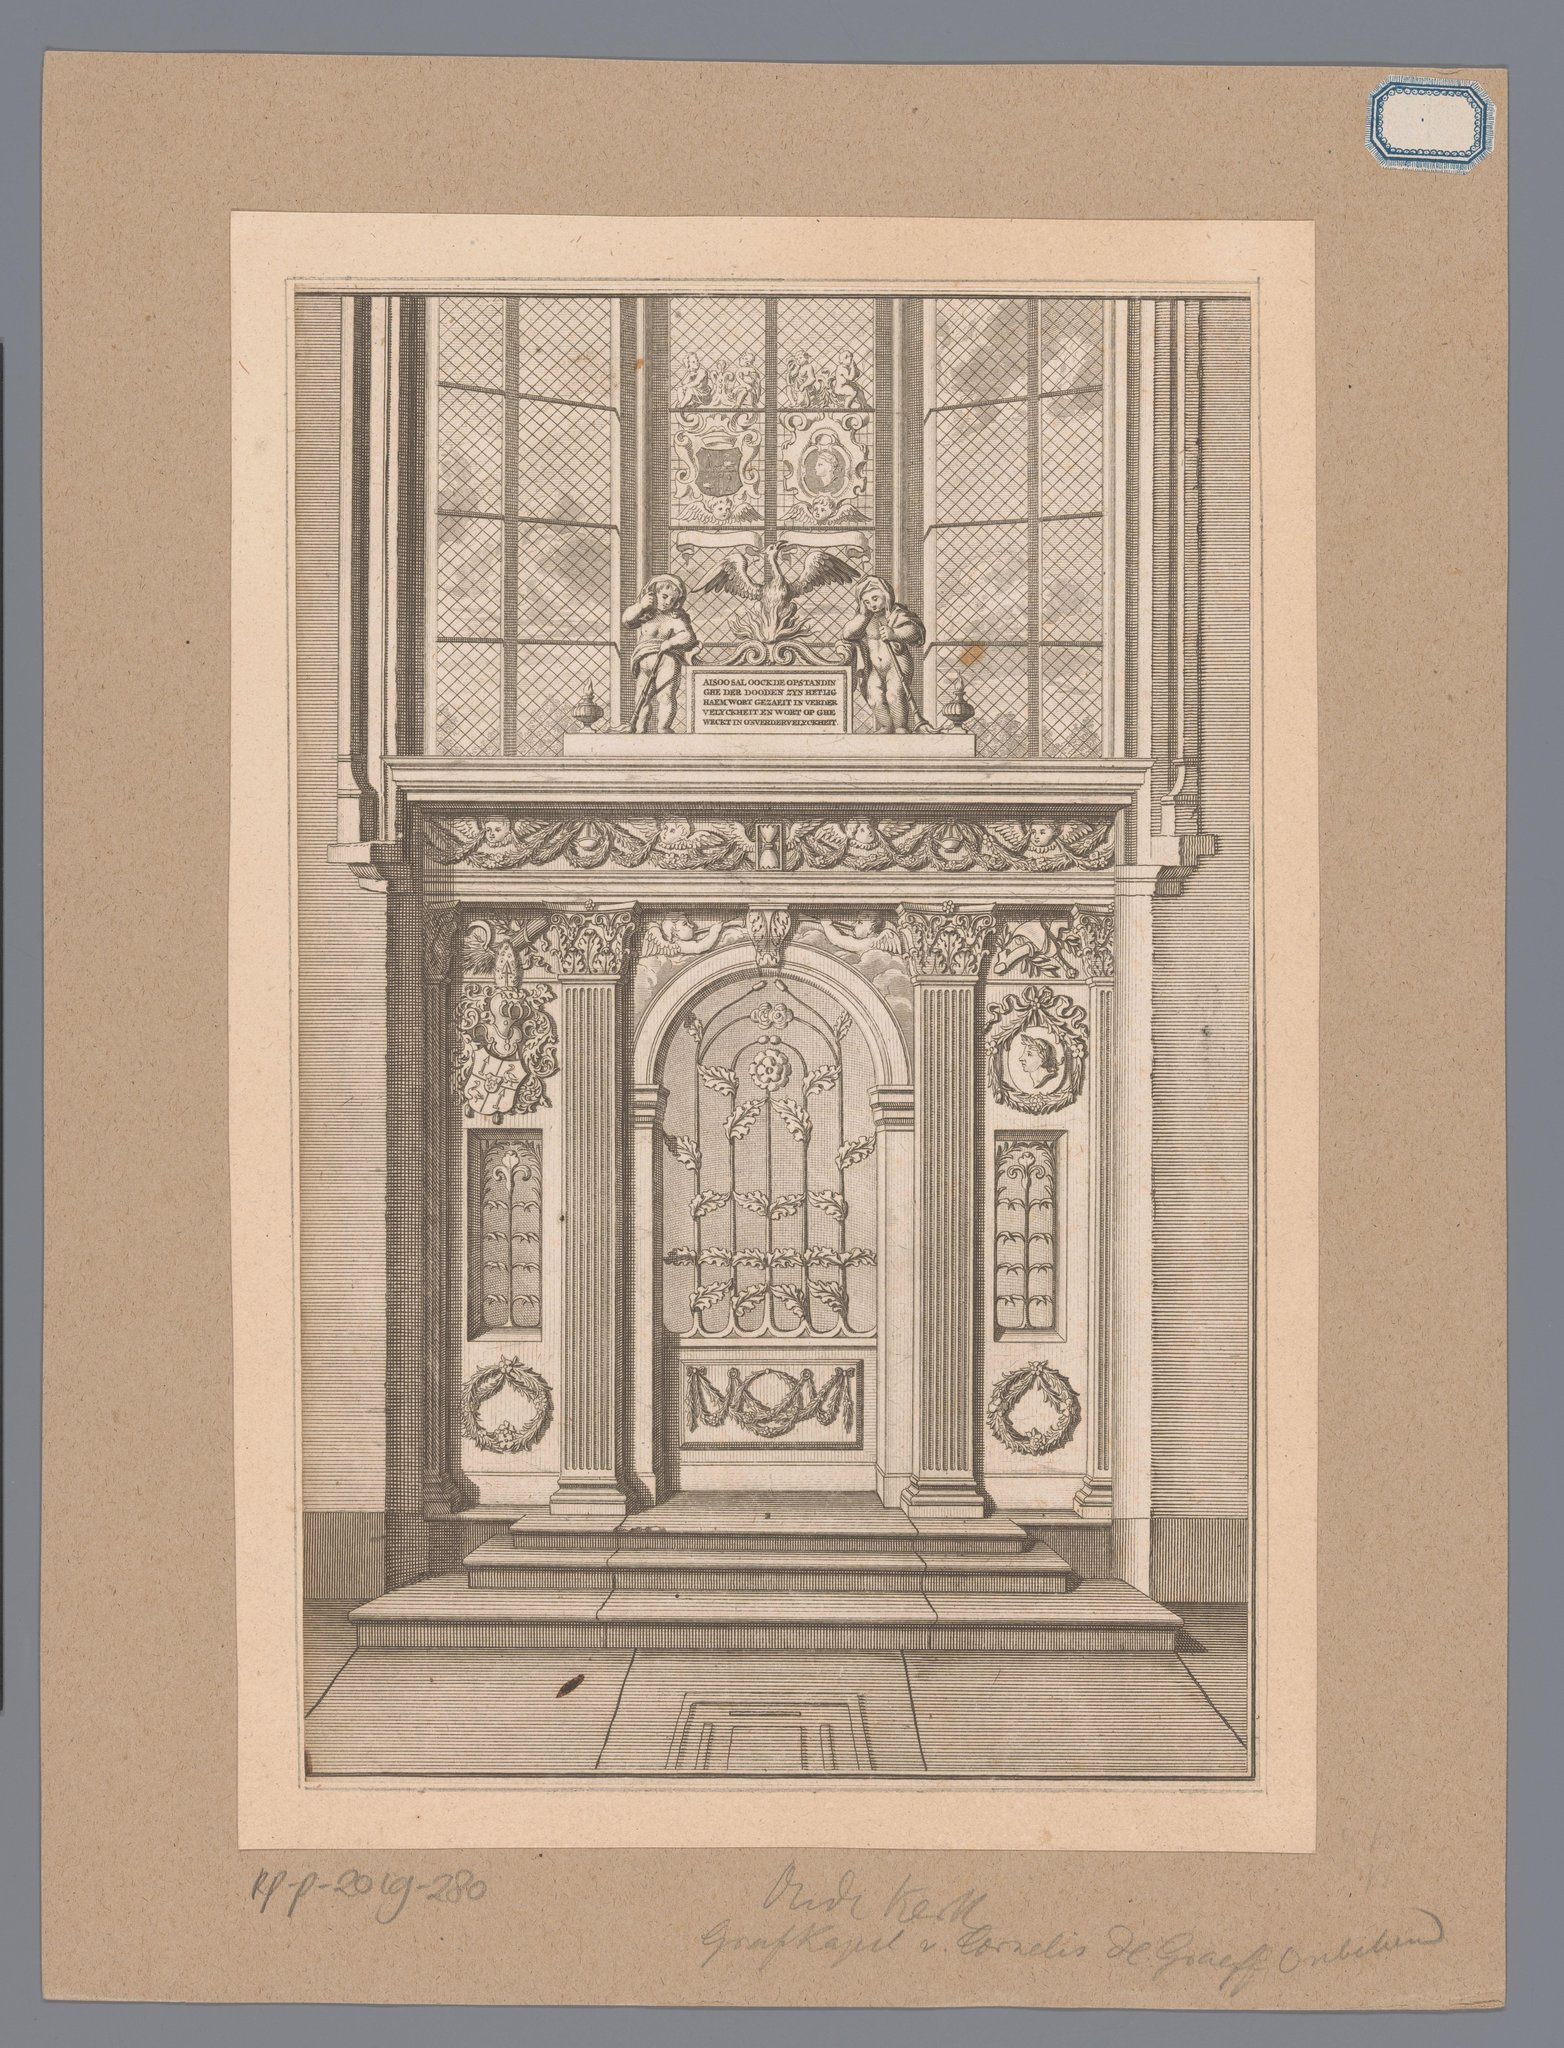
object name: book illustration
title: Grafmonument voor Cornelis de Graeff in de Oude Kerk te Amsterdam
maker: Anonymous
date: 1693-1694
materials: paper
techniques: engraving, etching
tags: amsterdam, mayor, cornelis de graeff, parts of church interior, grave-building, monumental tomb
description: Prent uit: Commelin, Caspar. Beschryvinge van Amsterdam, desselfs eerste oorspronk uyt den Huyse (…). Amsterdam: Abraham Wolfgang et al., 1693, tussen p. 436 en 437. Of uit: Commelin, Caspar. Beschryvinge van Amsterdam, zynde een naukeurige verhandelinge van desselfs eerste oorspronk uyt (…). Amsterdam: weduwe Aart Dircksz Oossaan, 1694, tussen p. 436 en 437. Latere staat van prent gebruikt in: Commelin, Caspar. Beschryvinge van Amsterdam, zynde een naukeurige verhandelinge van desselfs eerste oorspronk uyt (…). Amsterdam: Andries van Damme et al., 1726, tussen p. 436 en 437.